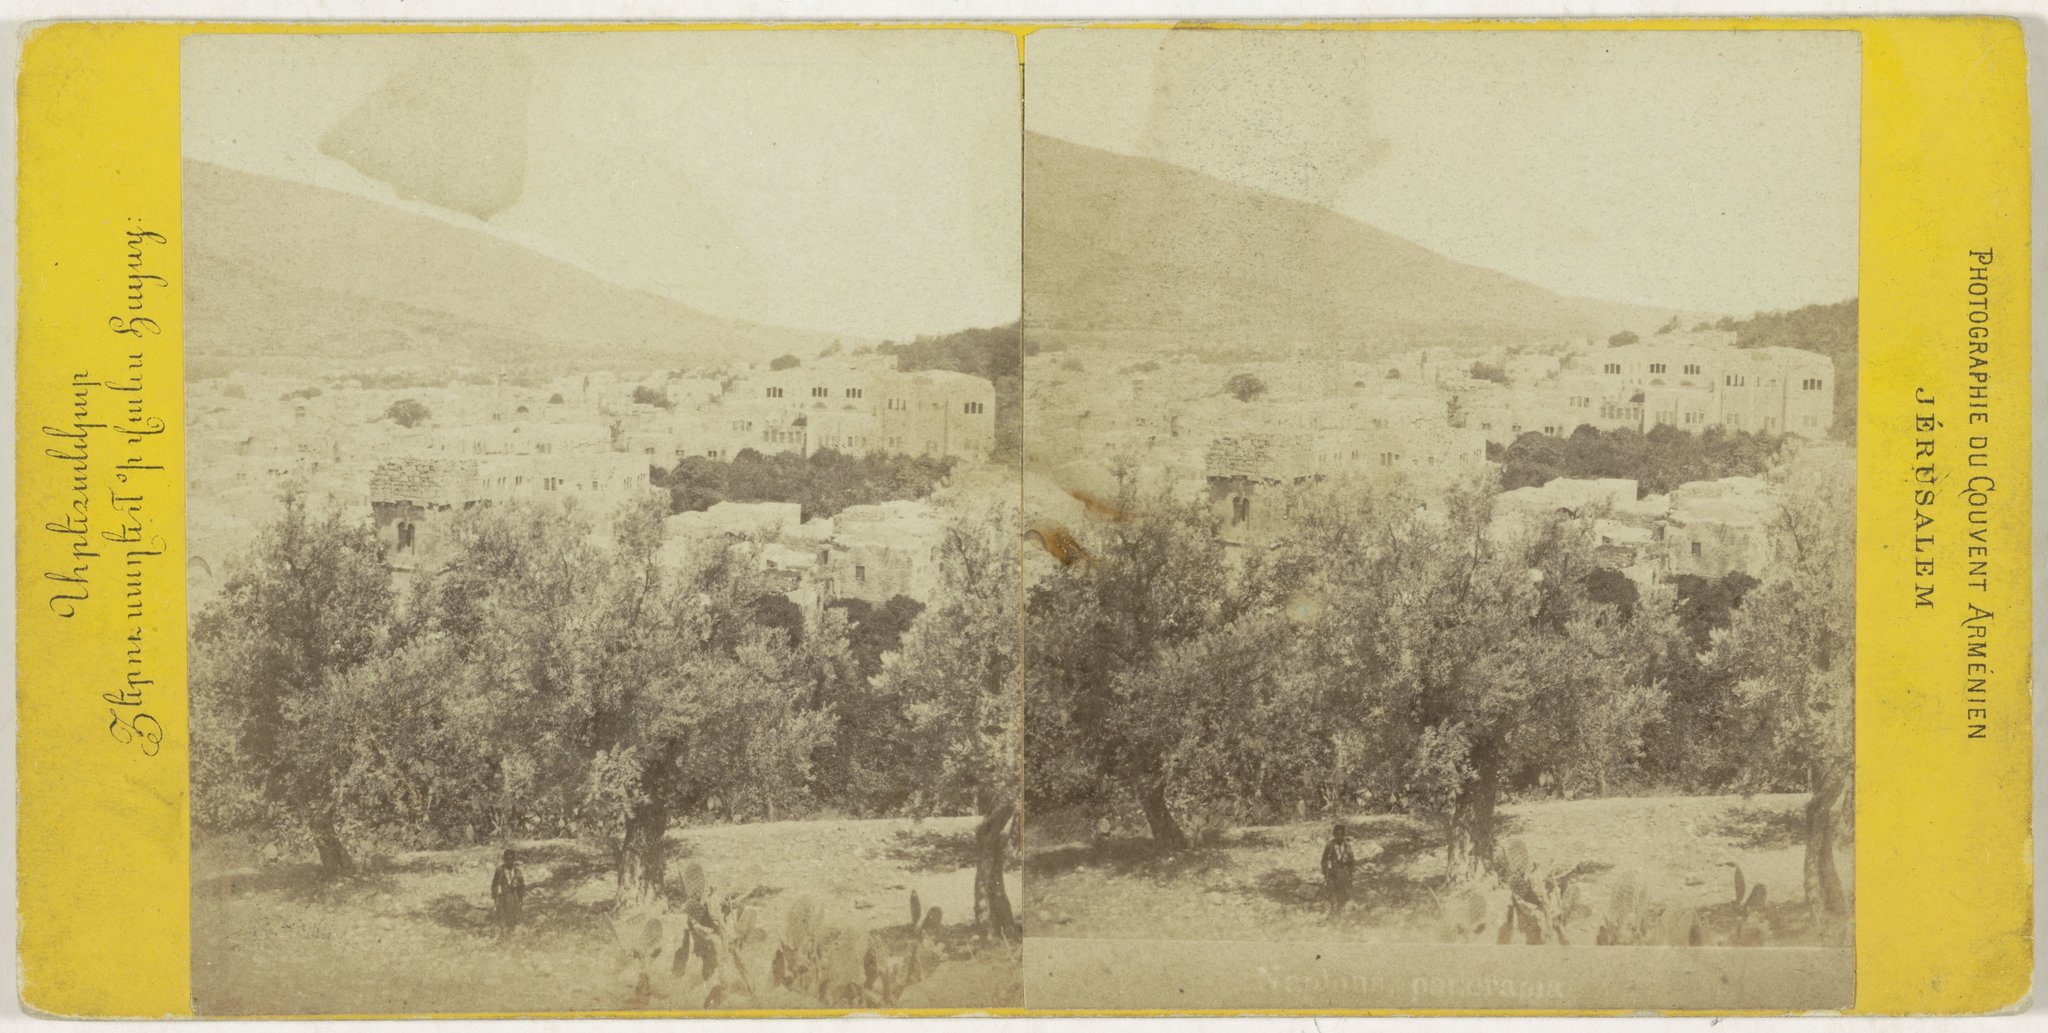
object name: stereograph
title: Gezicht op de Armeense wijk in Jeruzalem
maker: Anonymous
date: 1861-1870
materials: cardboard, paper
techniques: albumen print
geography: jerusalem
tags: city-view in general; 'veduta'